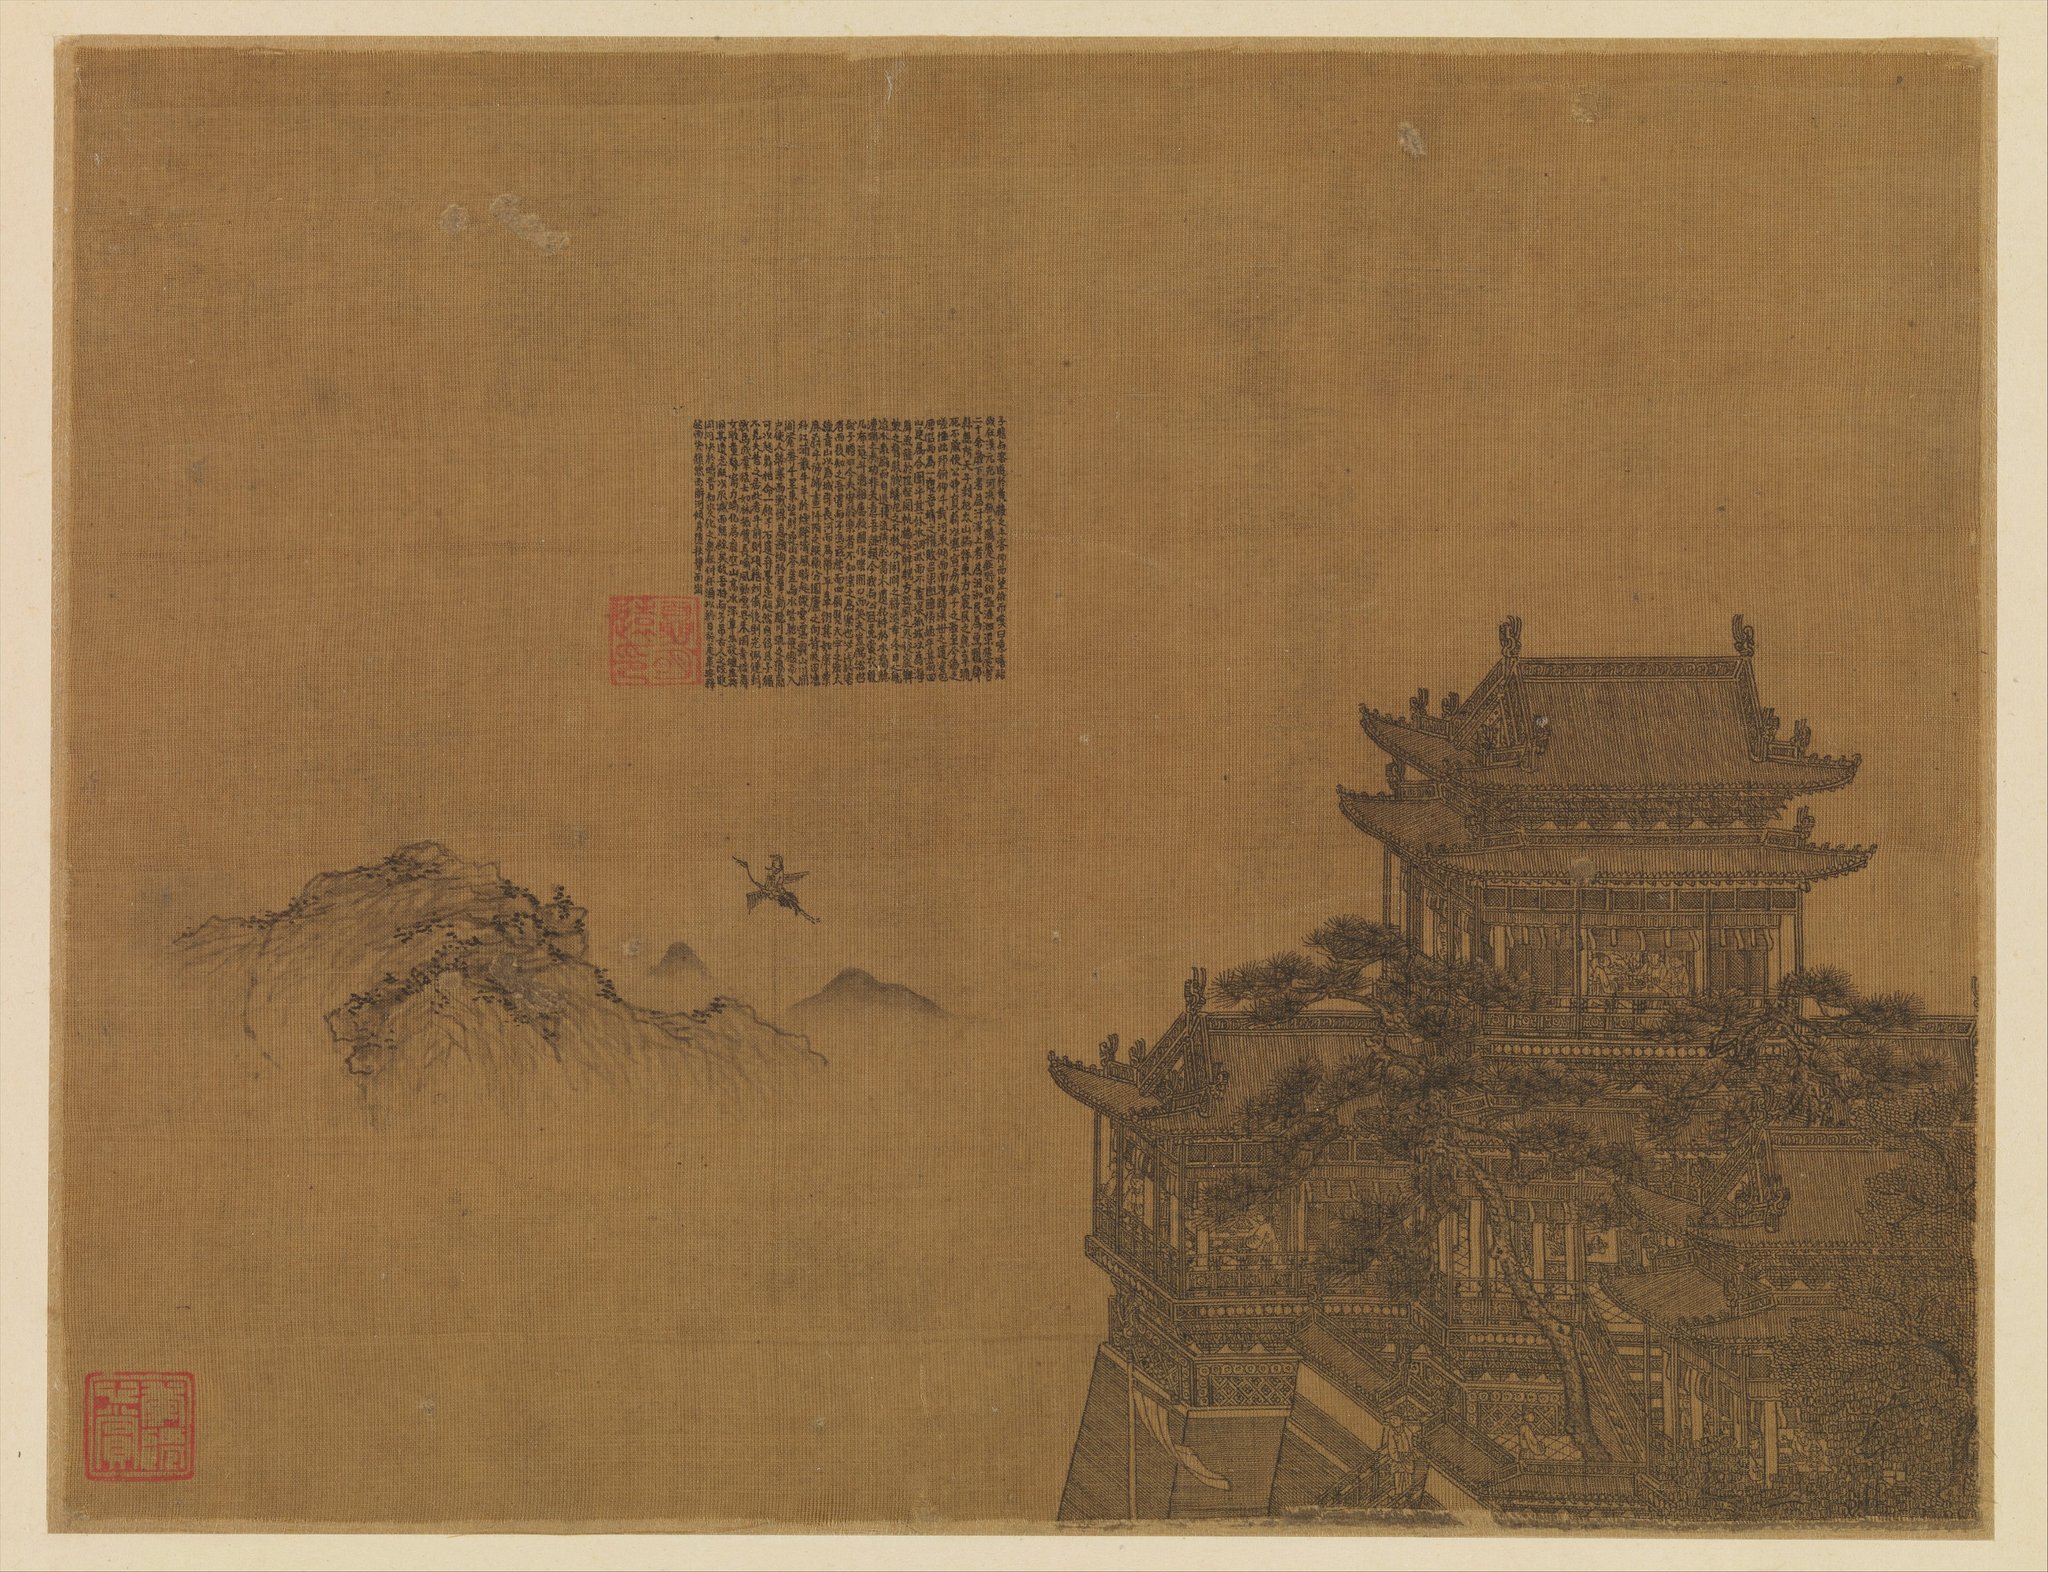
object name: album leaf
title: The Yellow Pavilion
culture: chinese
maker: xia yong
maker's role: artist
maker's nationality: chinese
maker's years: 1336-1370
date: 1350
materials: ink, silk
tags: pavilions